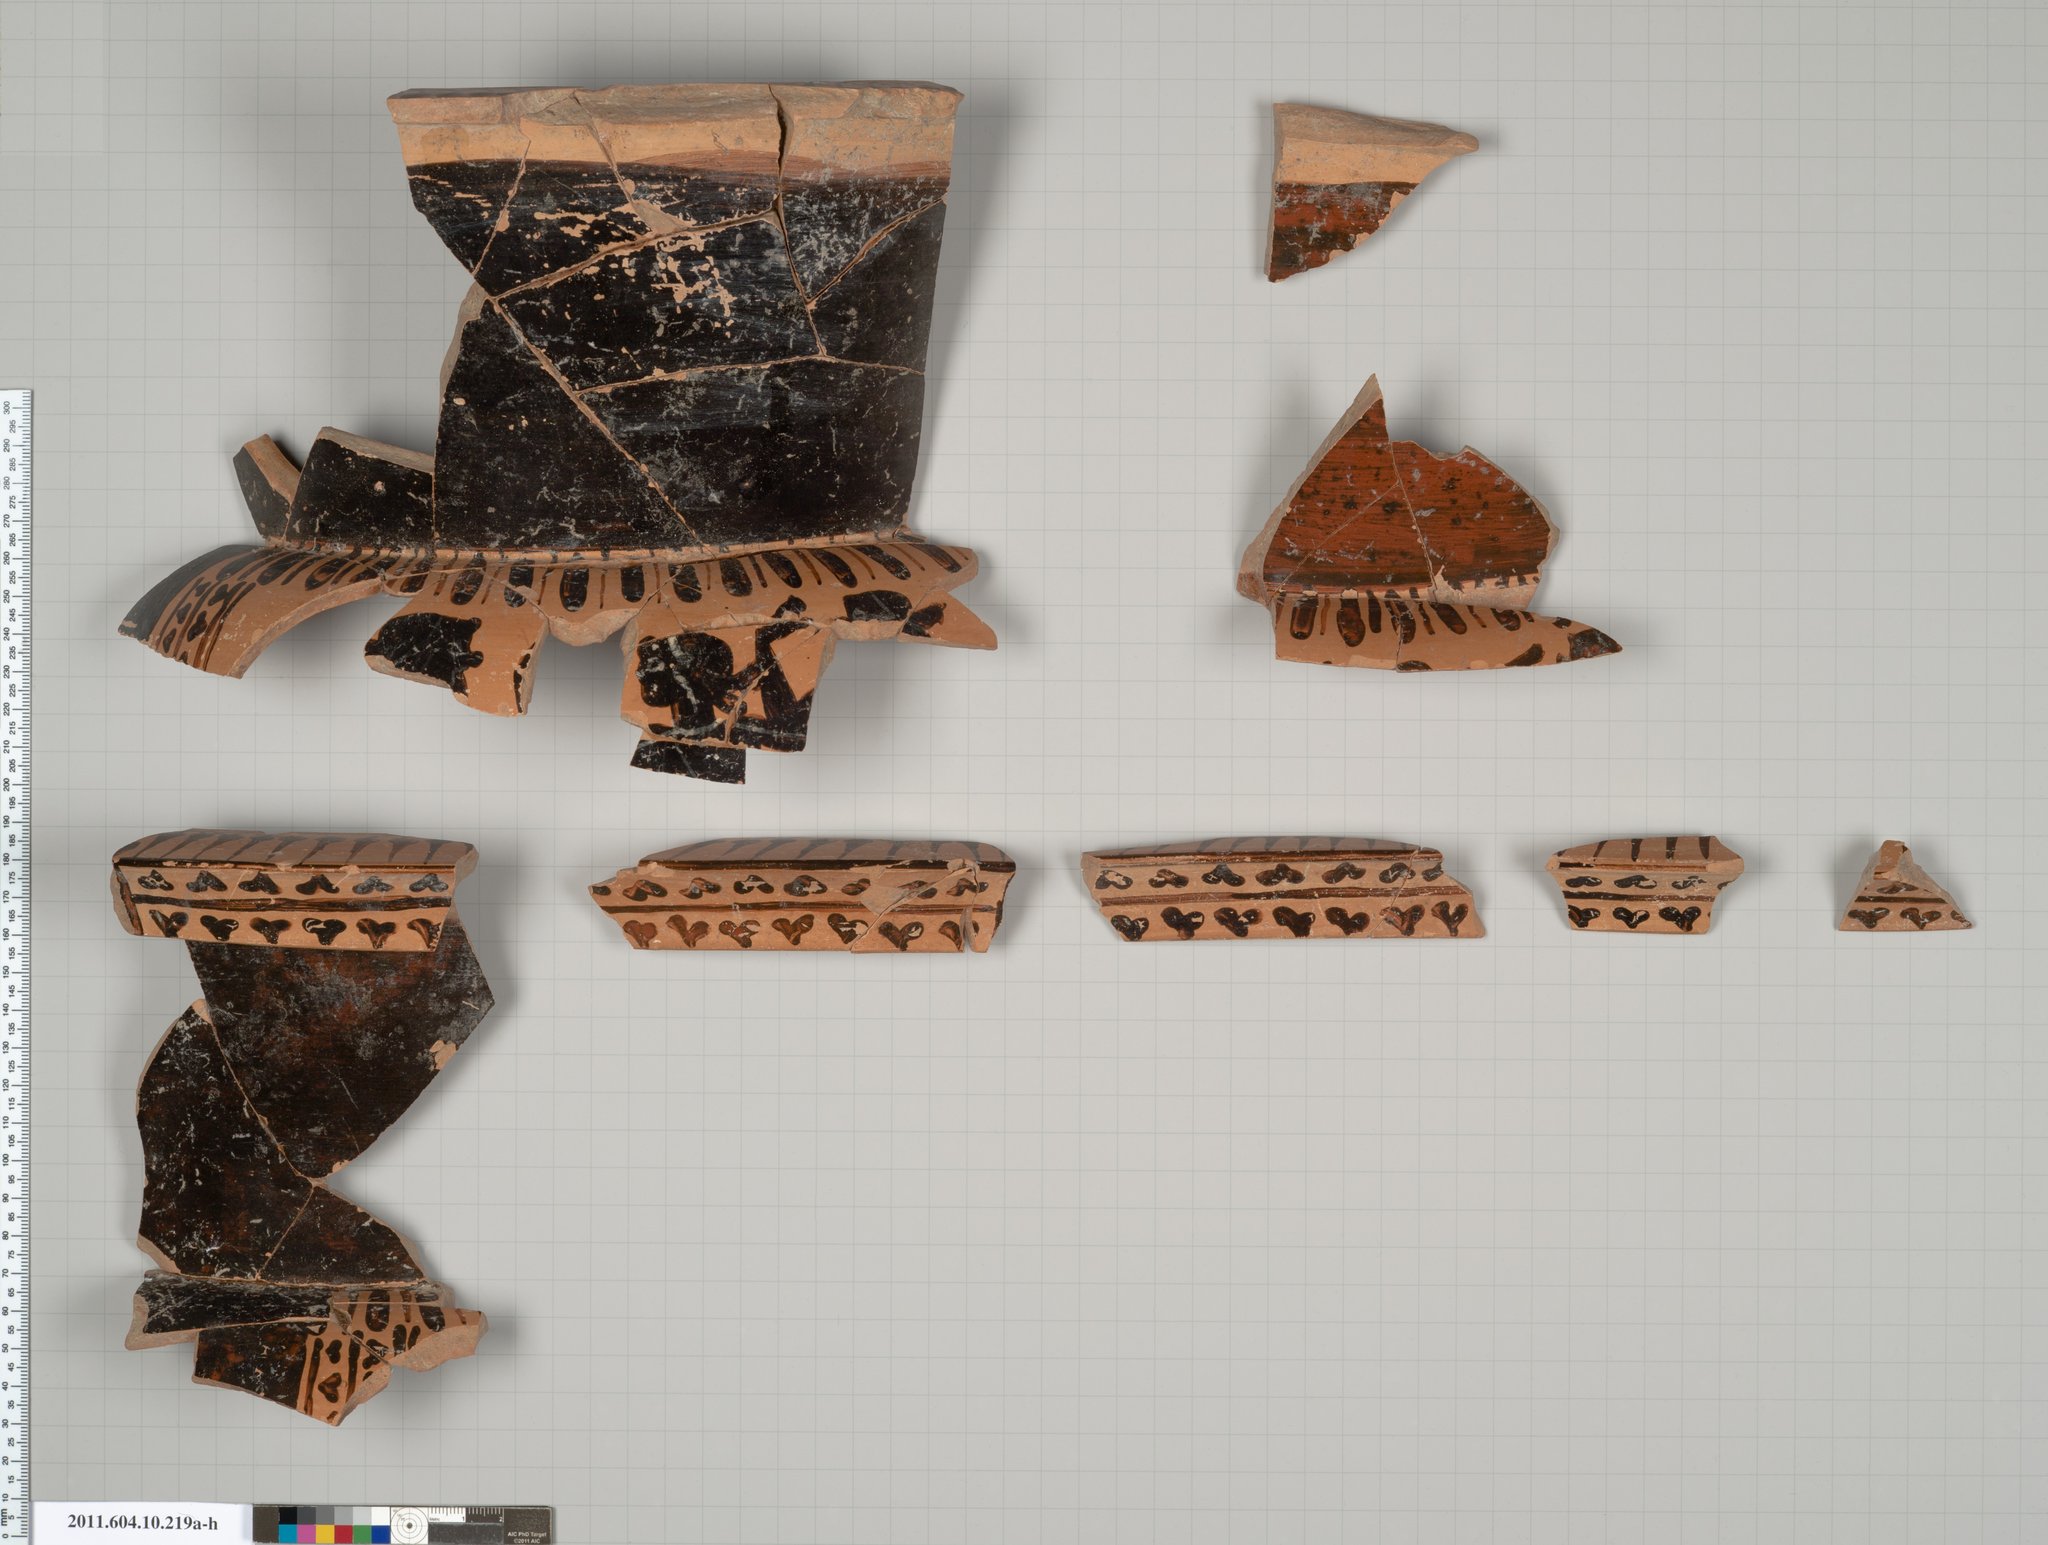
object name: column krater fragment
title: Terracotta fragments of a column-krater (deep bowl)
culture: etruscan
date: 500-480 BCE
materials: terracotta